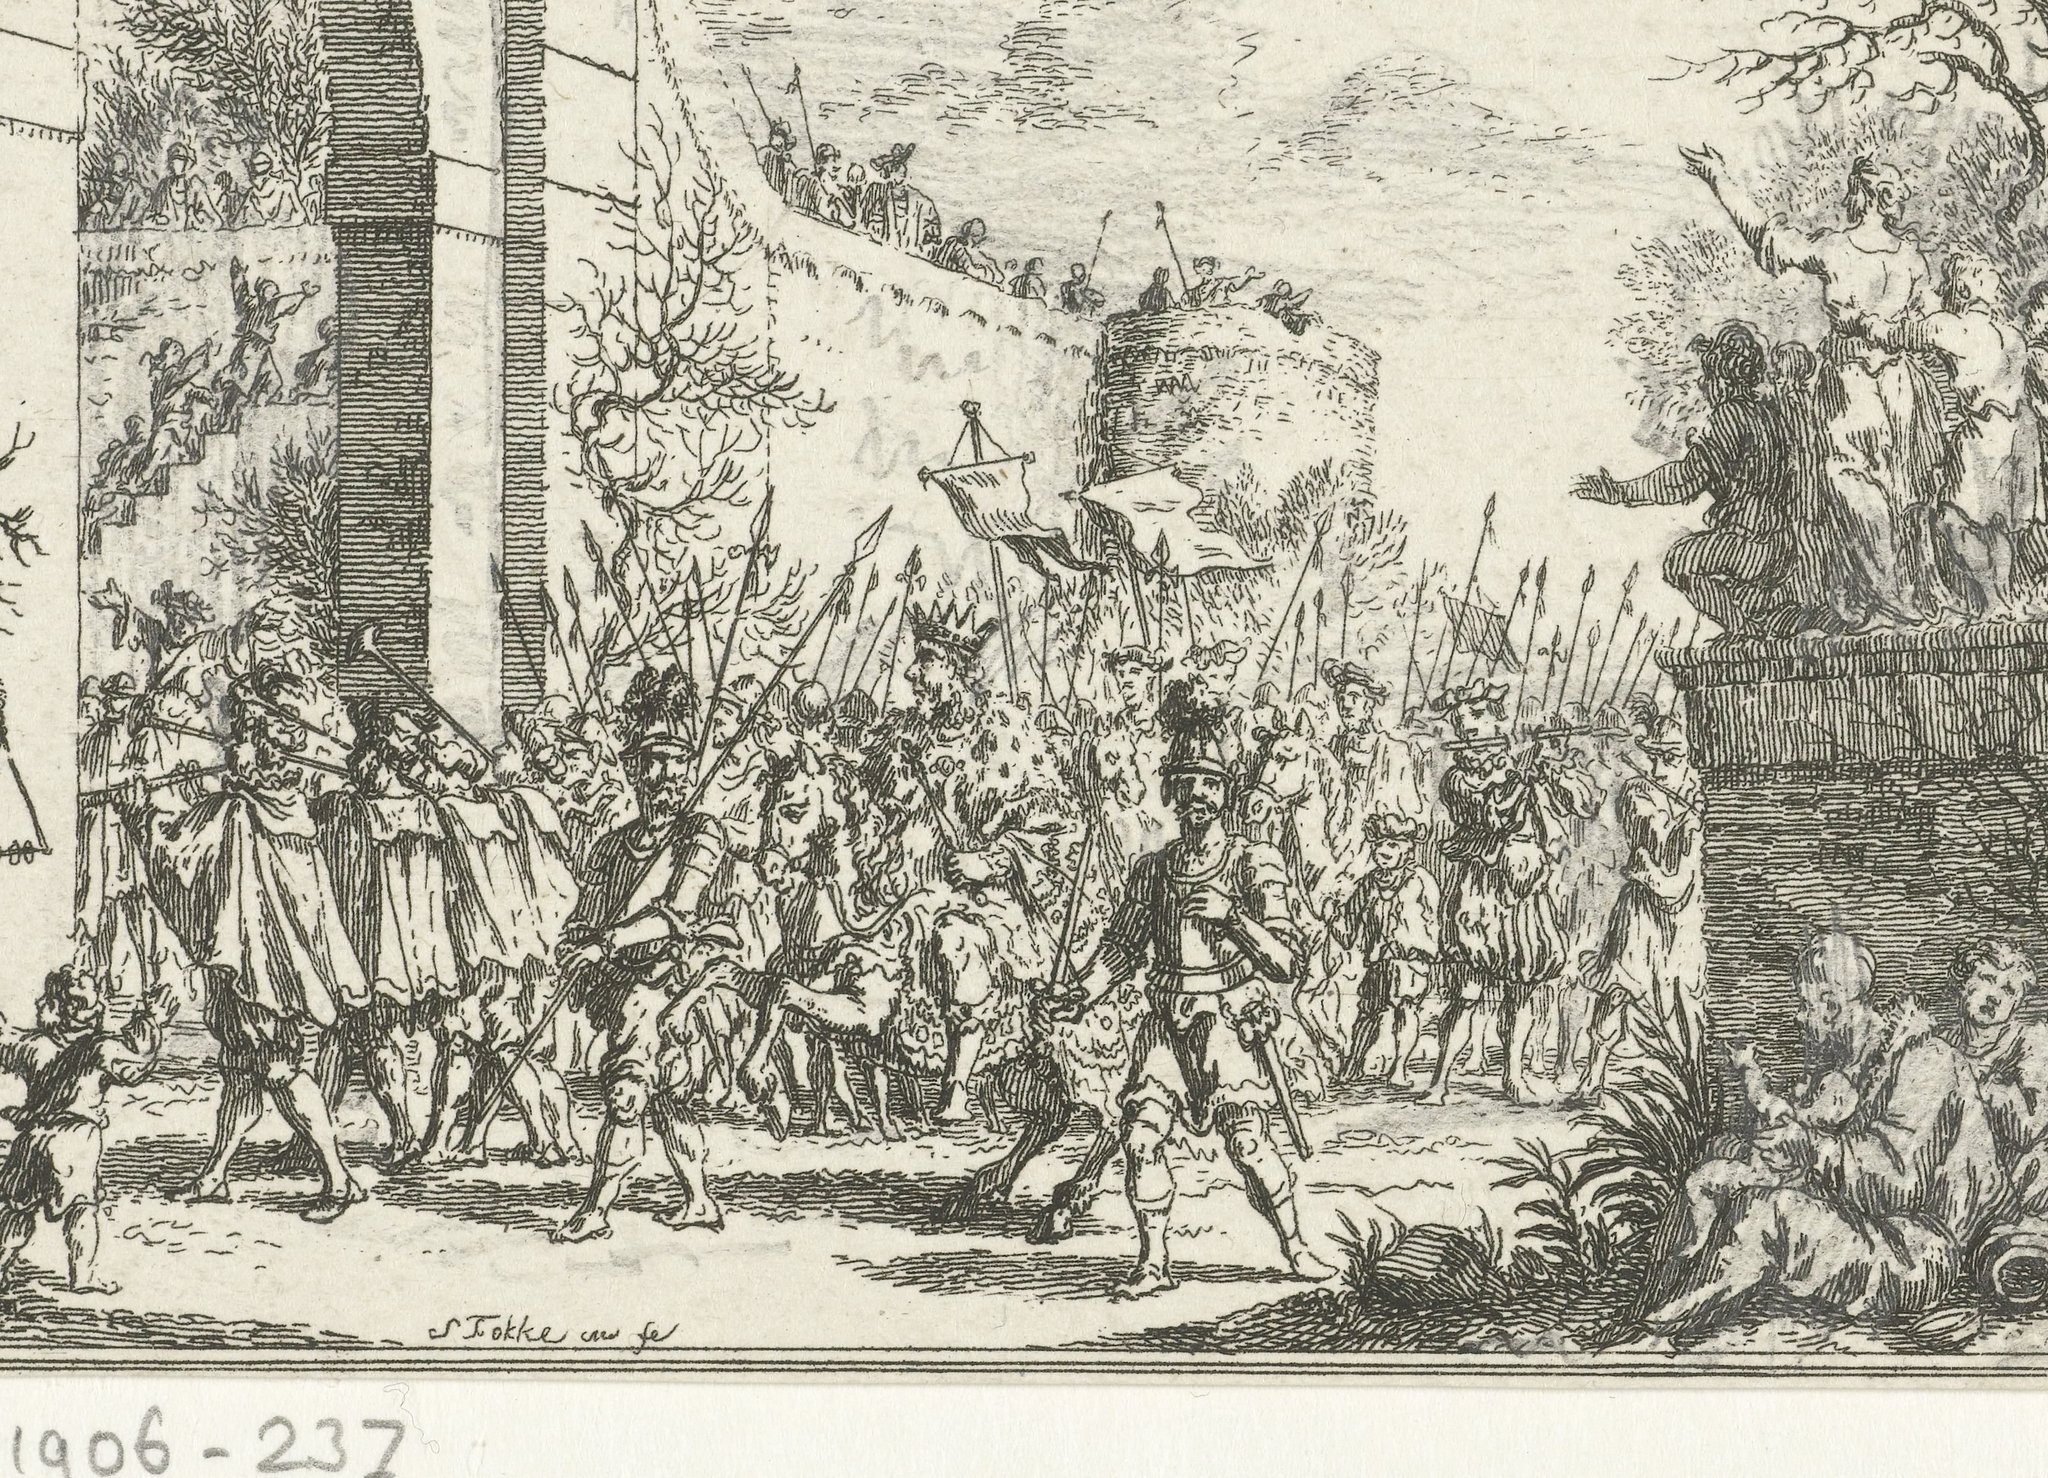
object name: print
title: Intocht van Karel VIII in Napels, 1495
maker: simon fokke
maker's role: draughtsman, print maker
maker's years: 1712-1784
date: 1722-1784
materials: paper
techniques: etching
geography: amsterdam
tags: conqueror triumphing, triumphal entry of victor, naples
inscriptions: collector's mark: Lugt 2228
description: Omringd door soldaten en muziekmakende figuren rijdt Karel VIII, koning van Frankrijk, in een feestelijke triomftocht te paard Napels binnen.